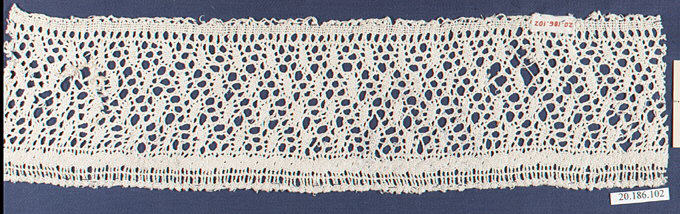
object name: strip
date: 1501-1700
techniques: lace